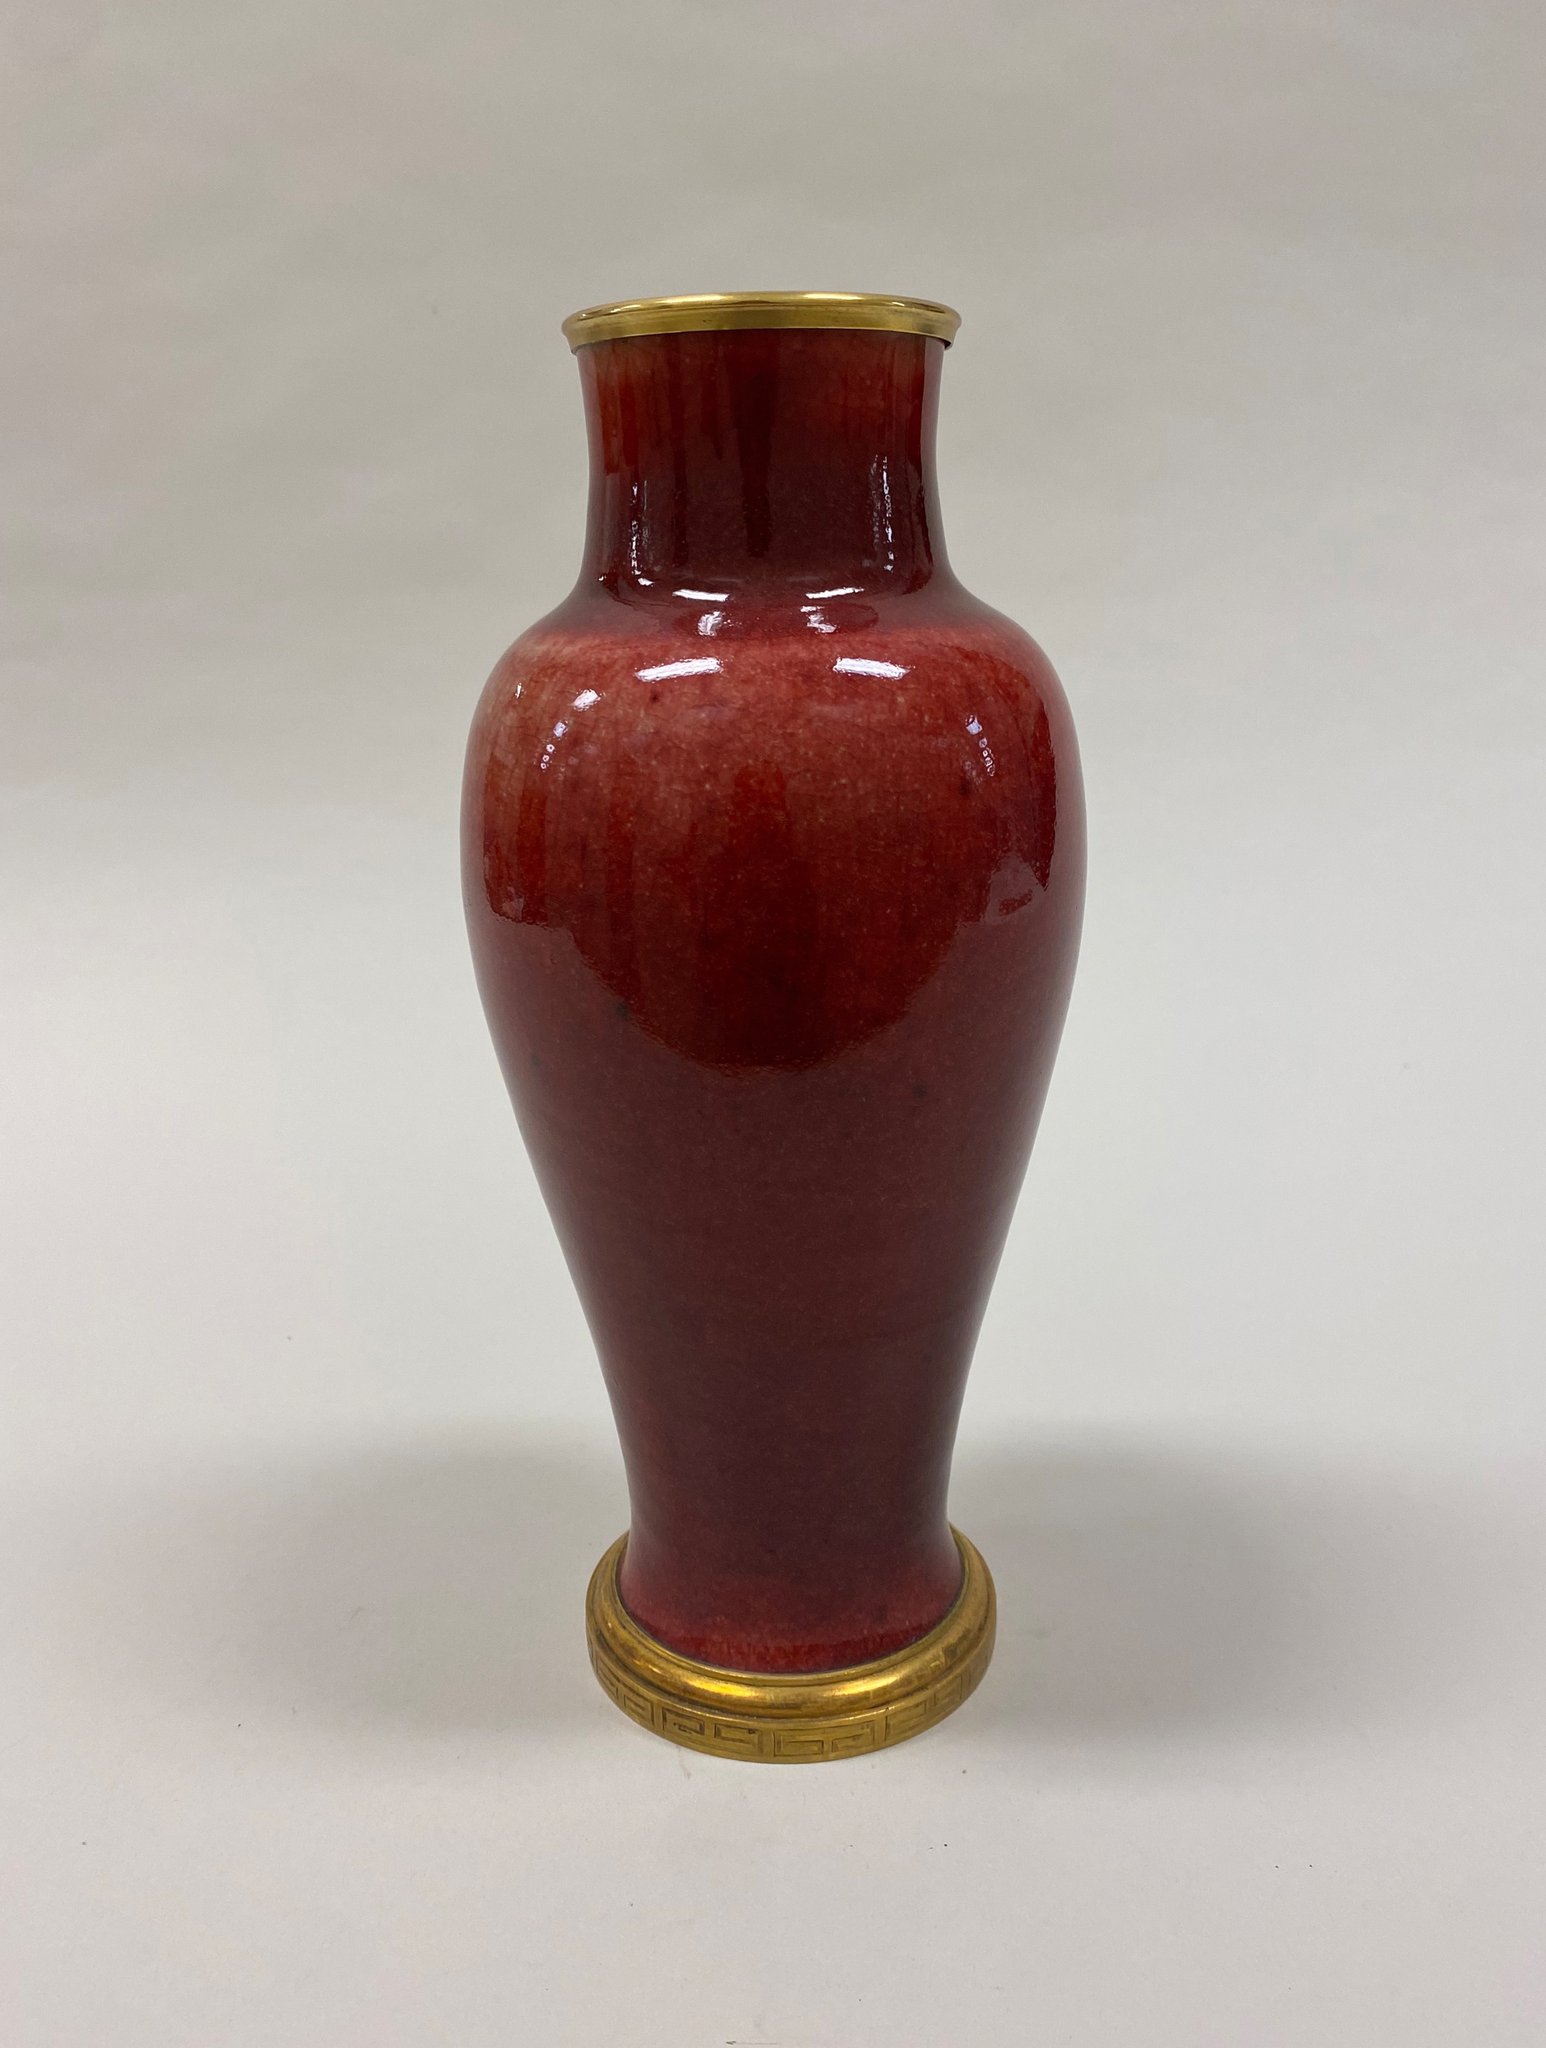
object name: vase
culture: chinese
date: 1667-1733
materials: copper, gilt bronze, glaze, porcelain